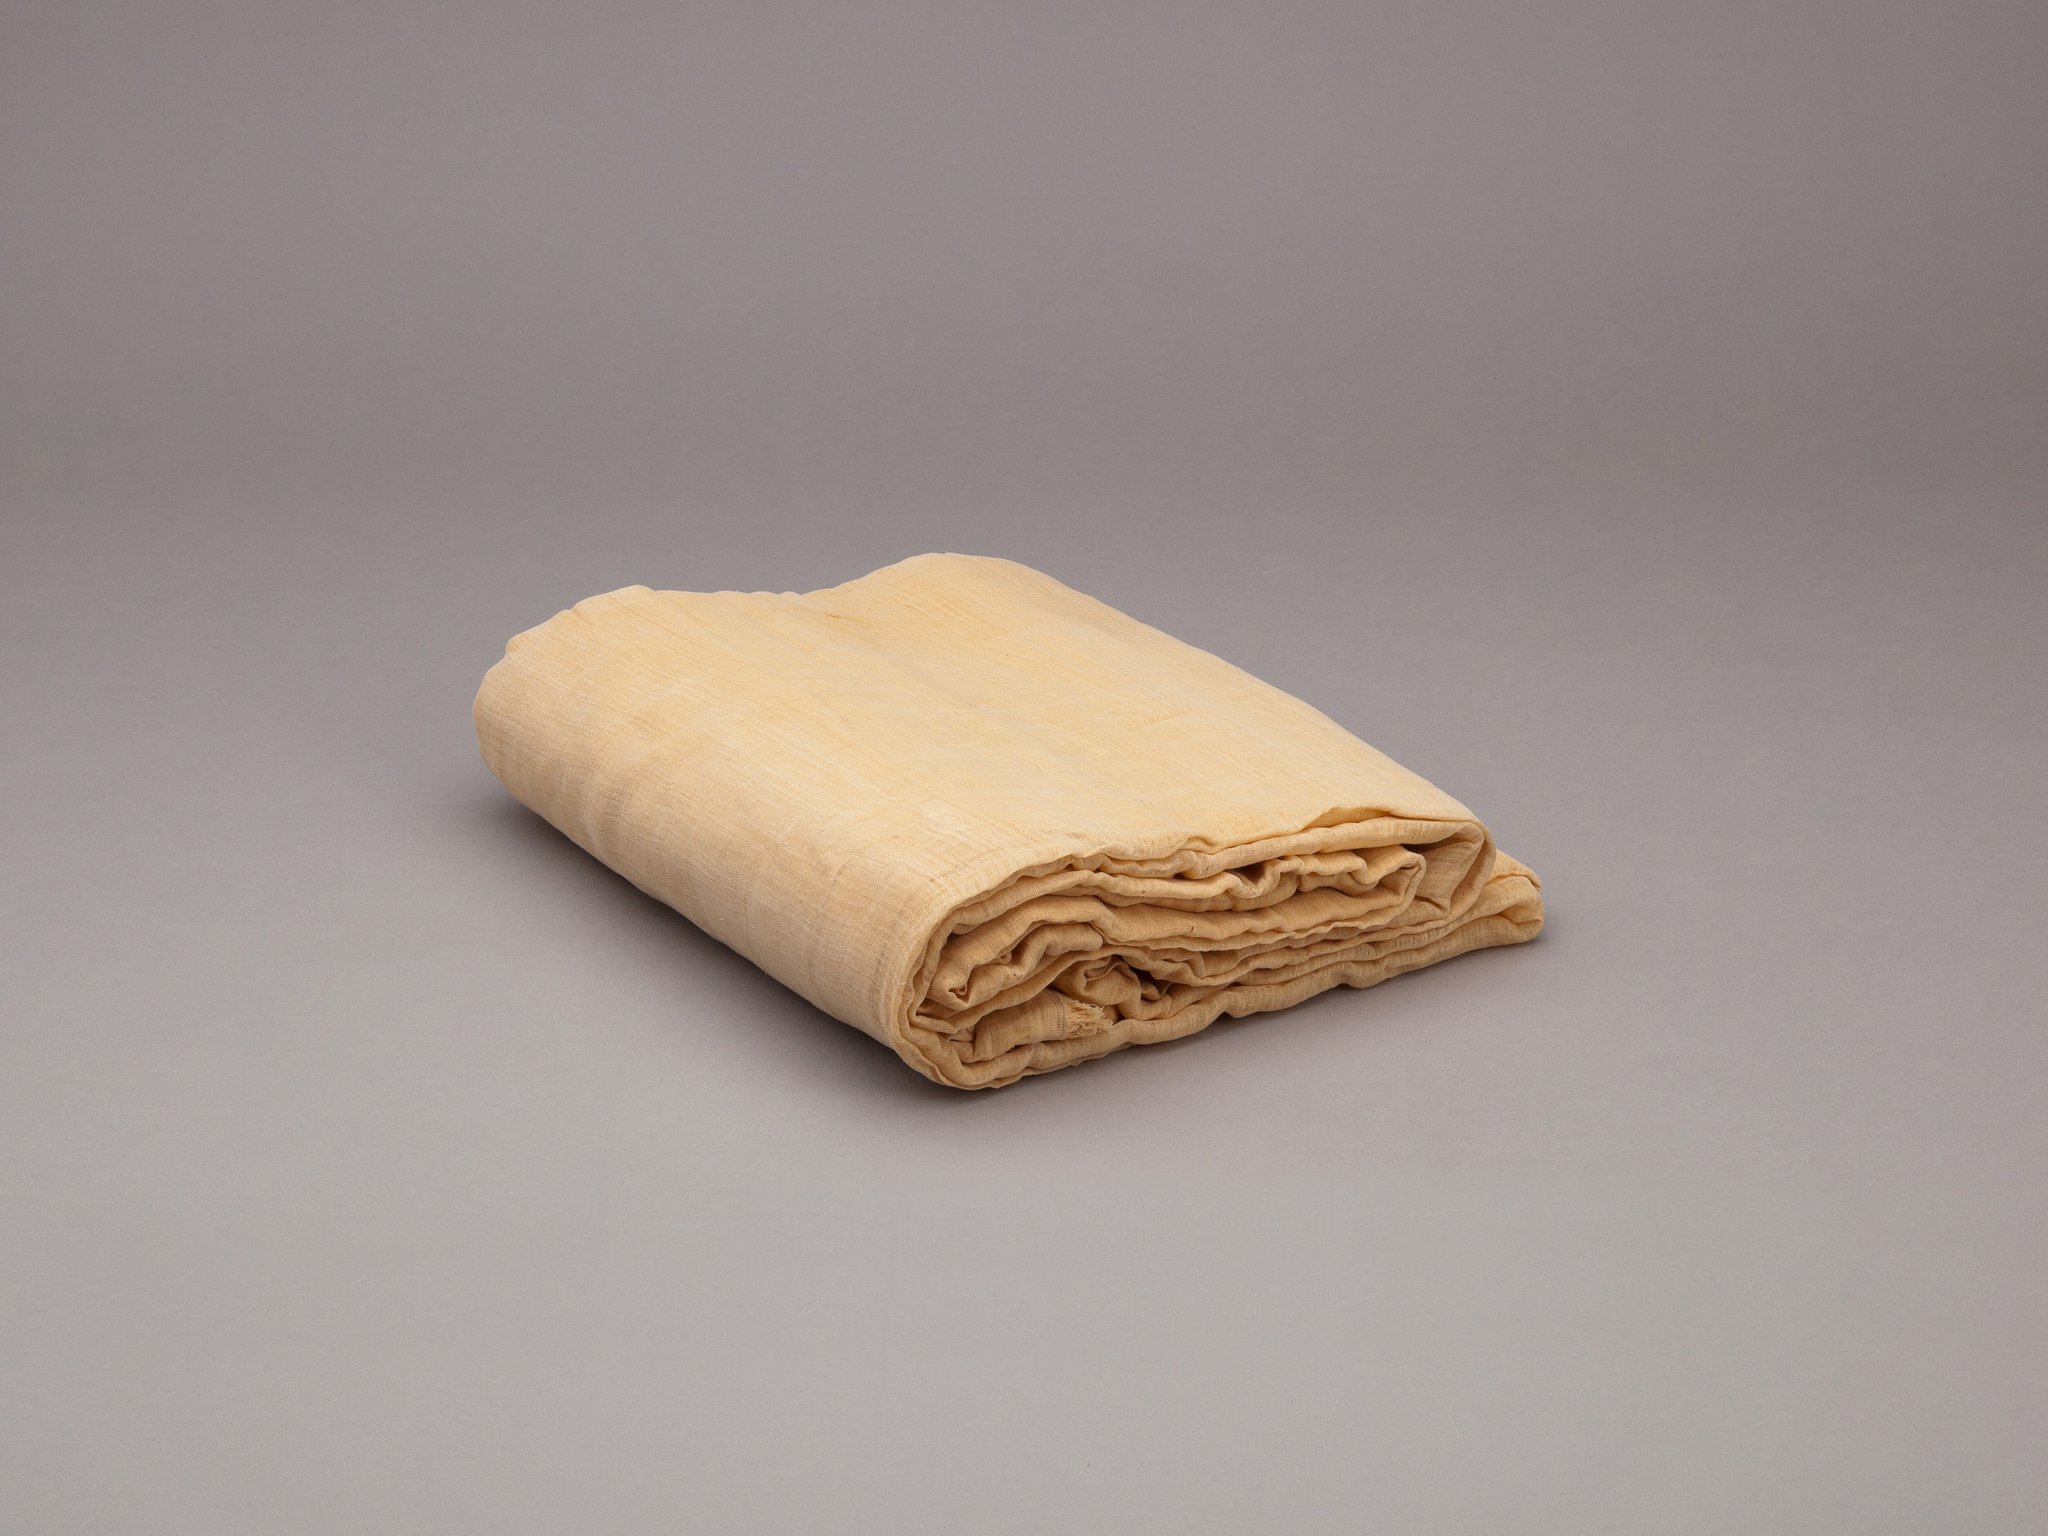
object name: linen mark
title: Sheet, linen mark, fine spin, medium weave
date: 1492-1473 BCE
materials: linen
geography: egypt